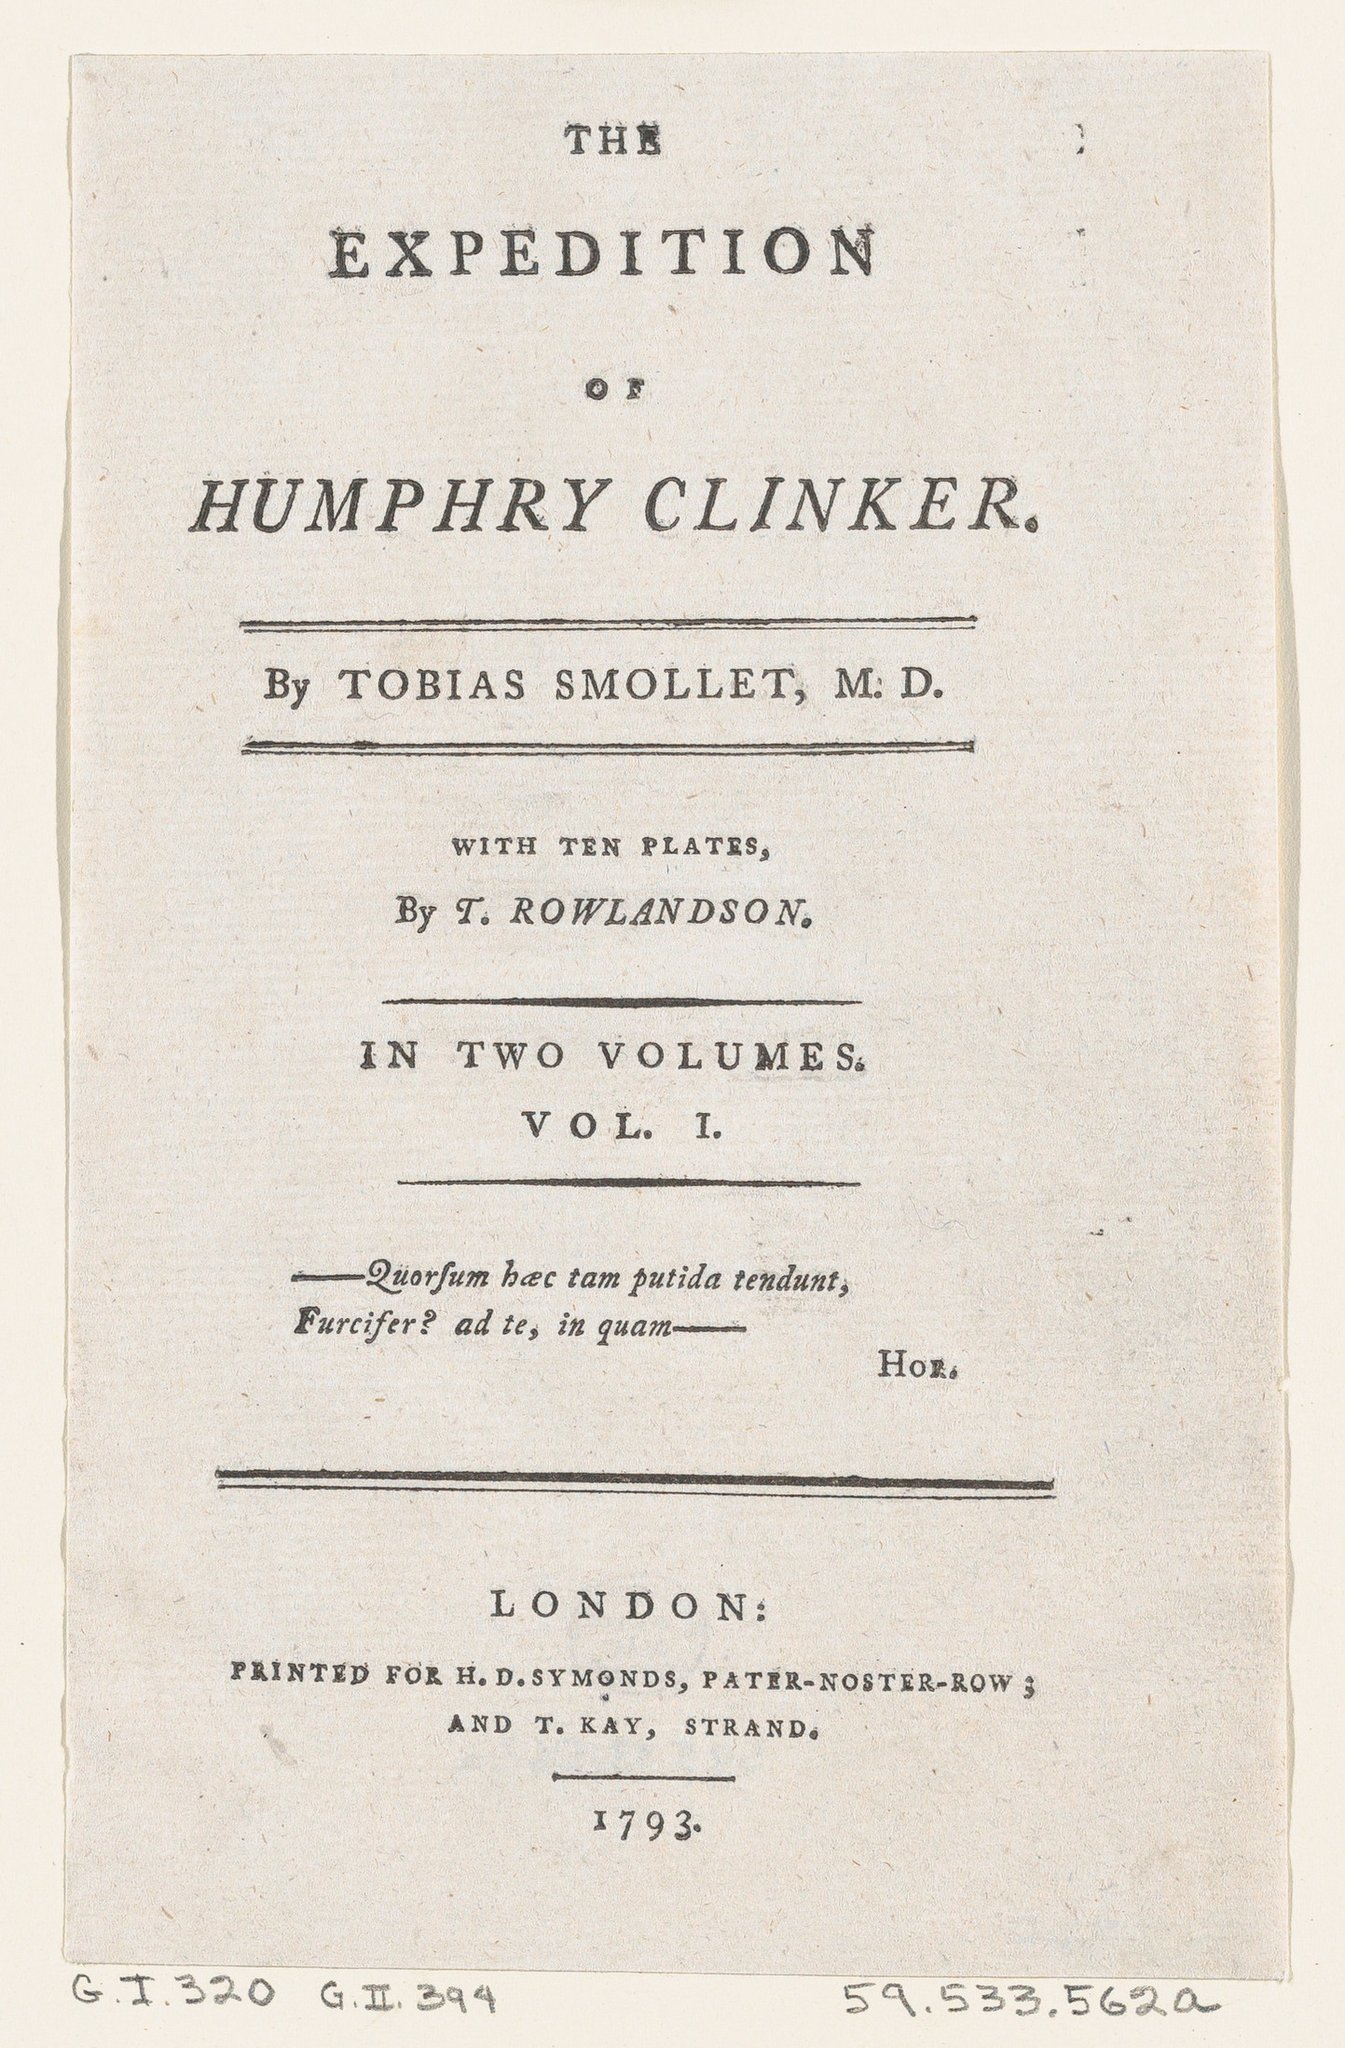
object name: print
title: Title Page, from Tobias Smollett's "The Expedition of Humphry Clinker" (London, 1793), Vol. 1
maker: thomas rowlandson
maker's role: artist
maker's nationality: british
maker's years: 1757-1827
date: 1793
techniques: letterpress